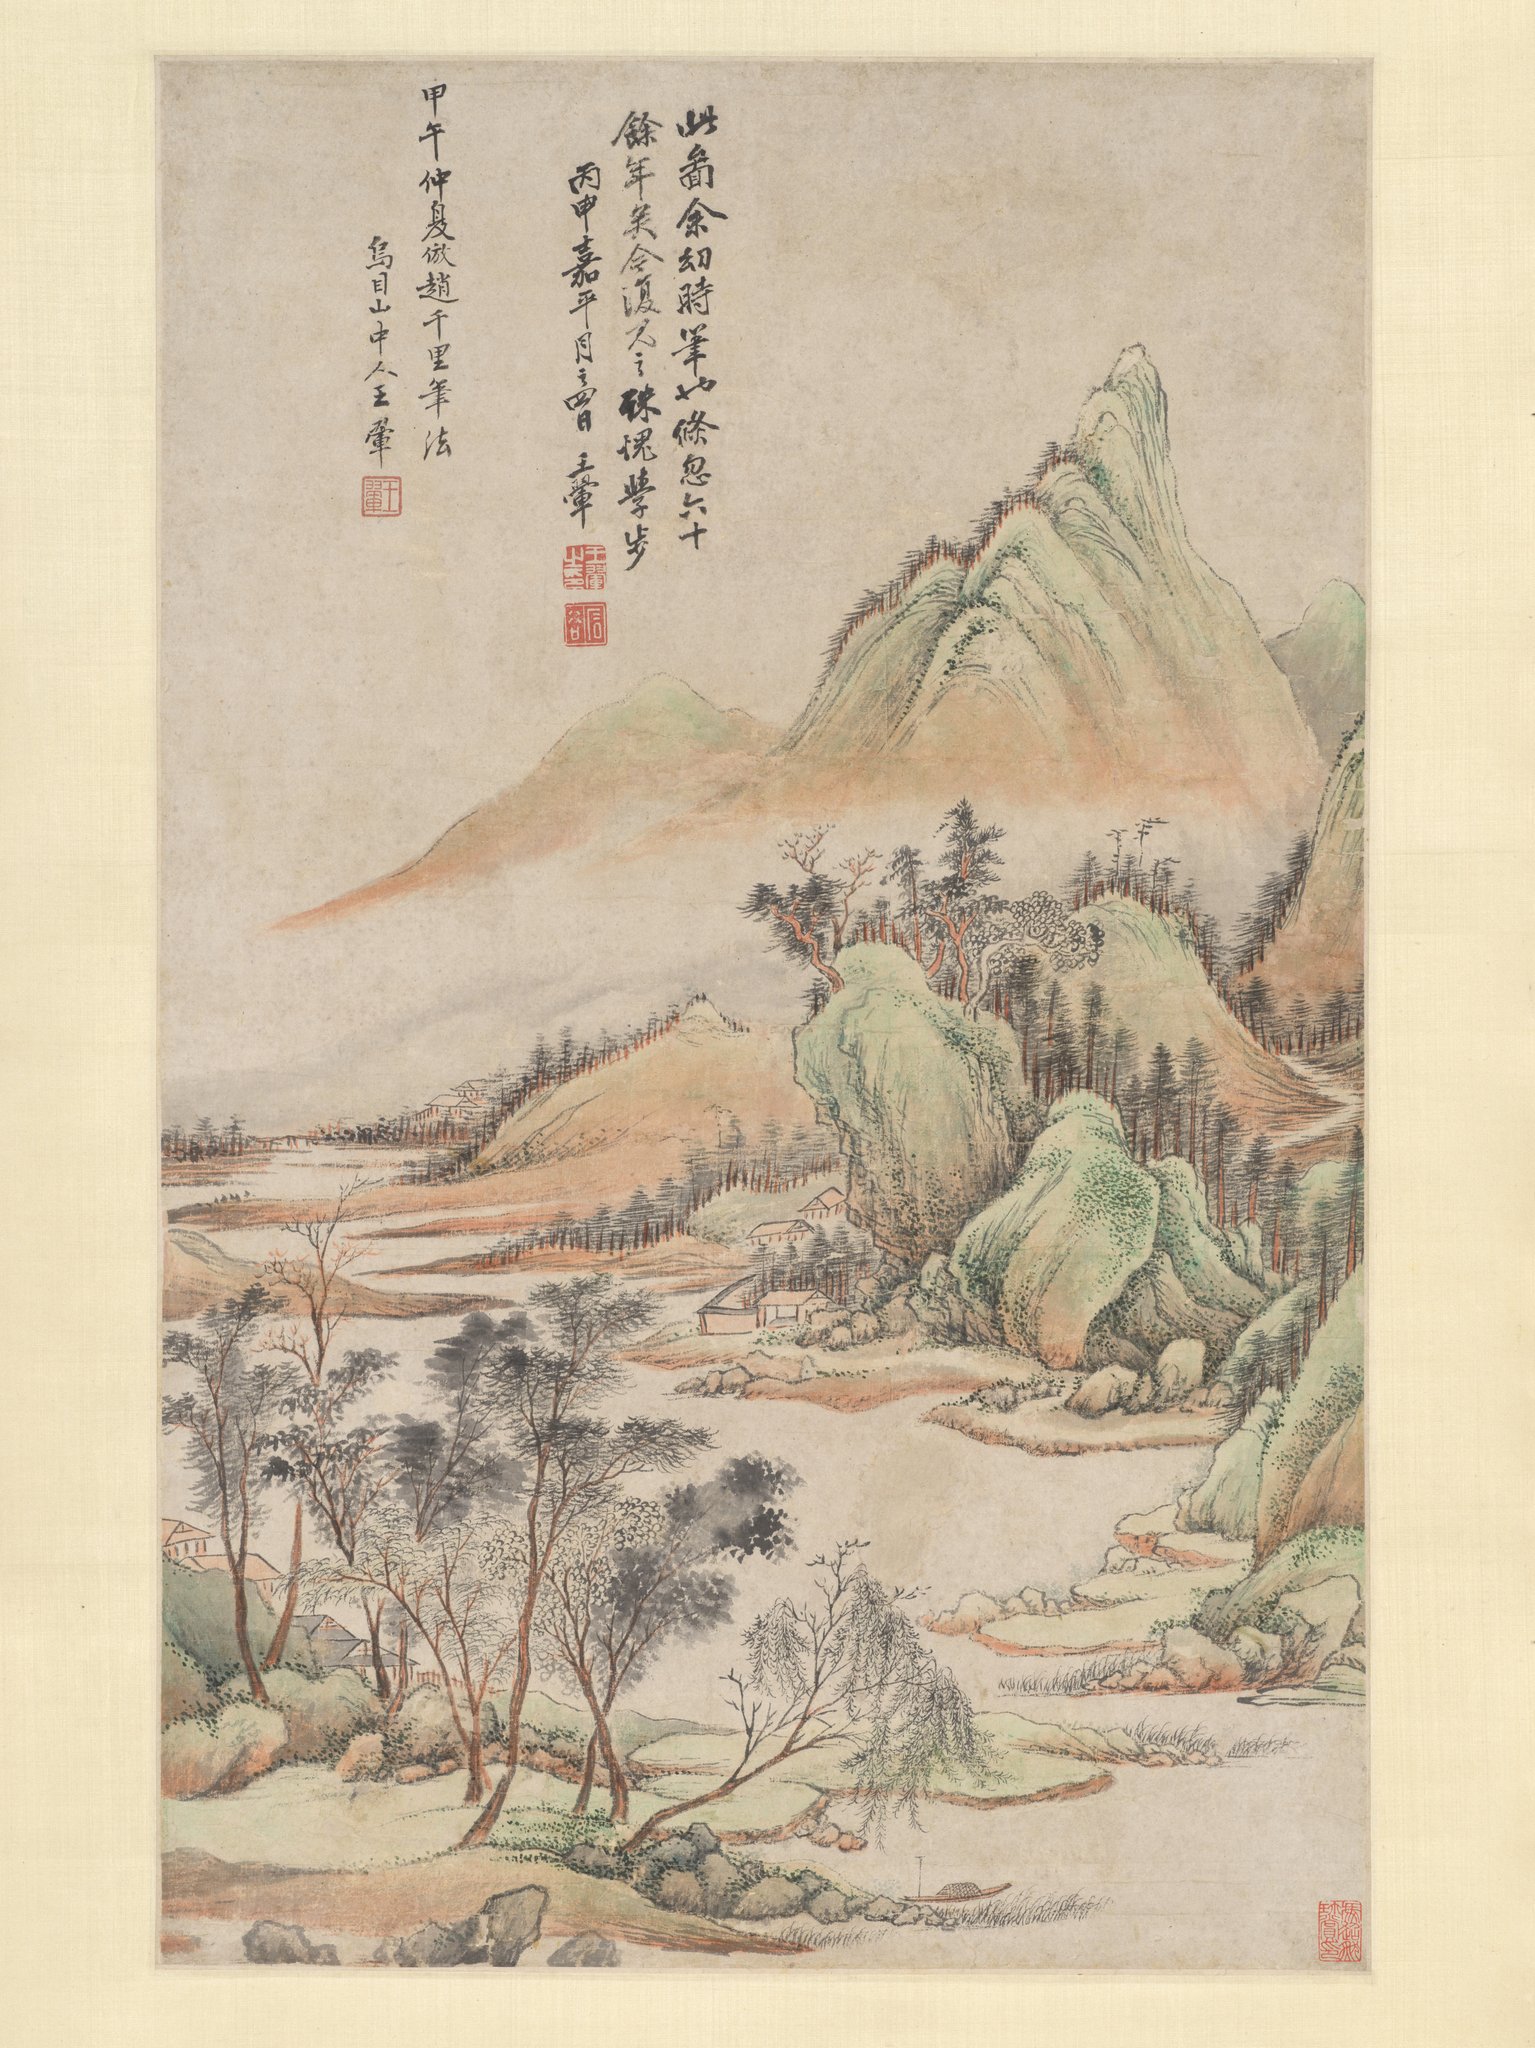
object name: hanging scroll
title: Landscape in the Style of Zhao Boju (Fang Zhao Boju shanshui)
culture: chinese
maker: wang hui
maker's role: artist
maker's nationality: chinese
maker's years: 1632-1717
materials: ink, paper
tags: mountains,landscapes